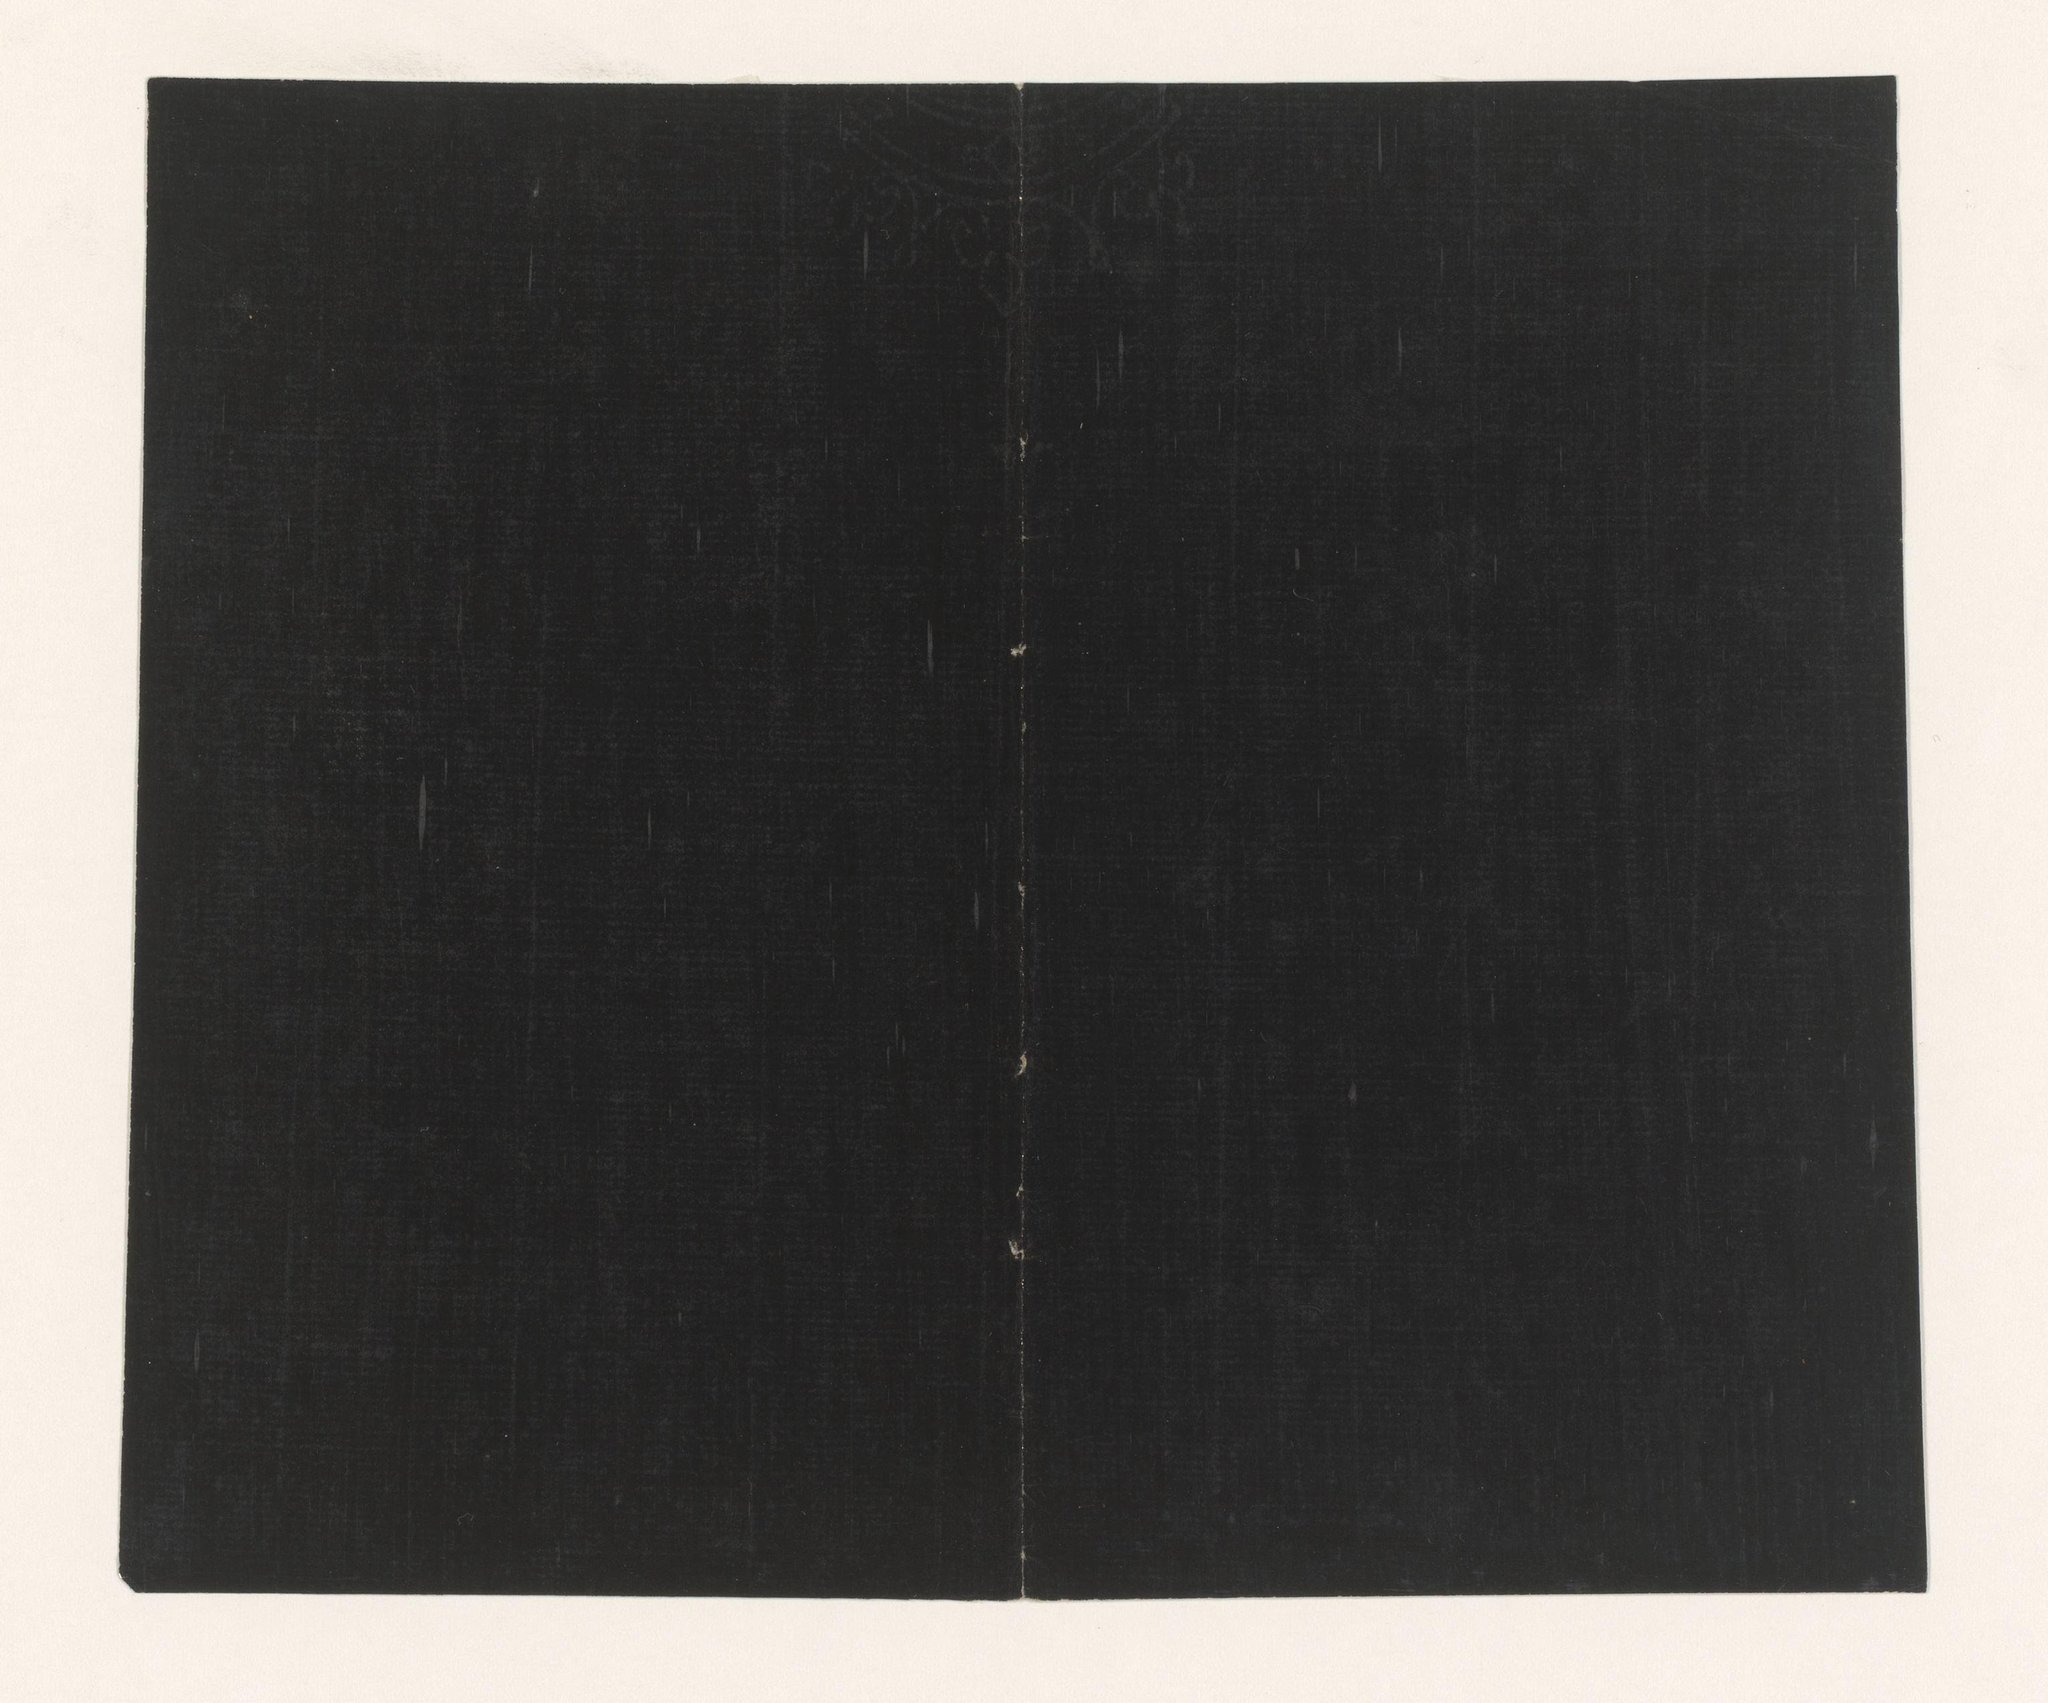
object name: wrapper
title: Effen zwart papier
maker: Anonymous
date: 1800-1900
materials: paint, paper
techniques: painting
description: Effen zwart papier. Gebruikt als omslag.